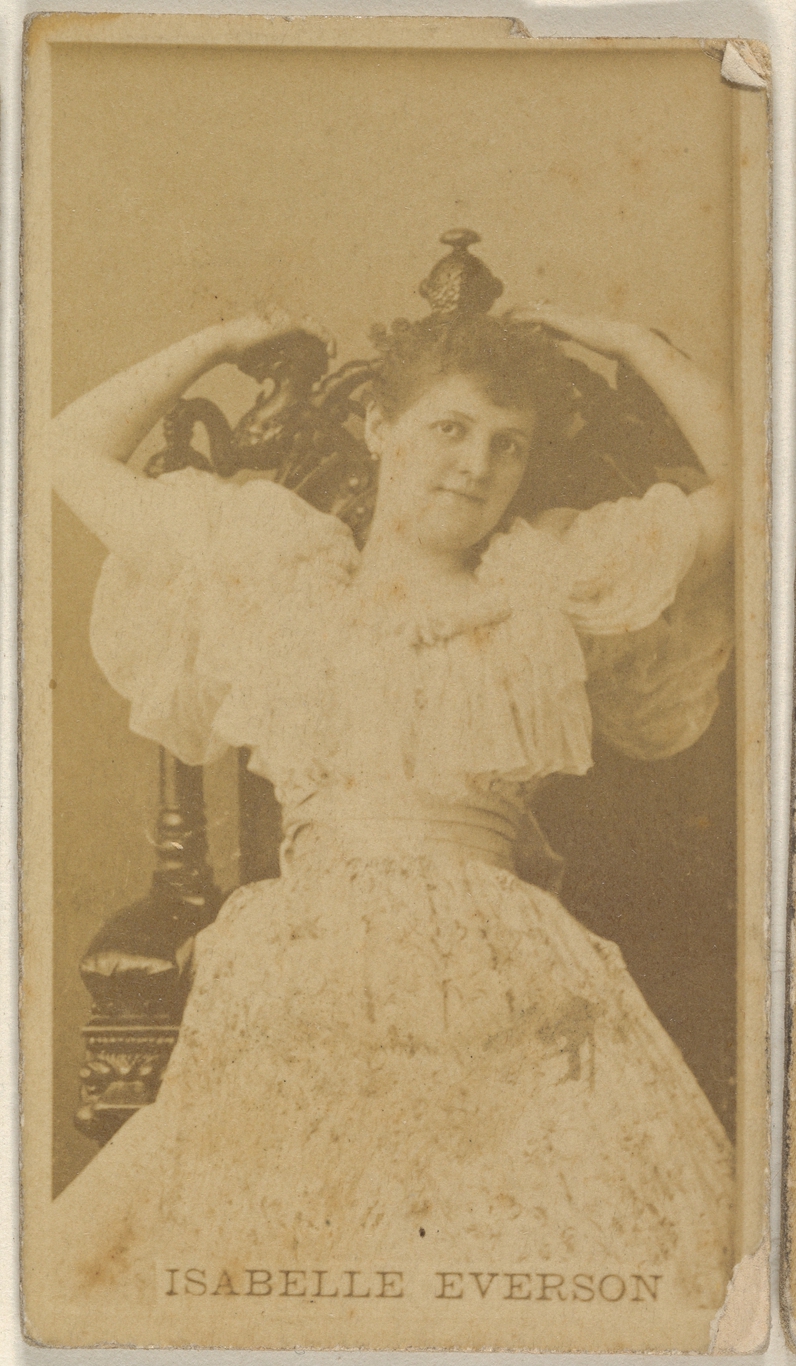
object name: photograph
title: Isabelle Everson, from the Actors and Actresses series (N45, Type 8) for Virginia Brights Cigarettes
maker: allen & ginter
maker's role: publisher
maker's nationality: american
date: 1888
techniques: albumen silver print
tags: portraits,women,actresses